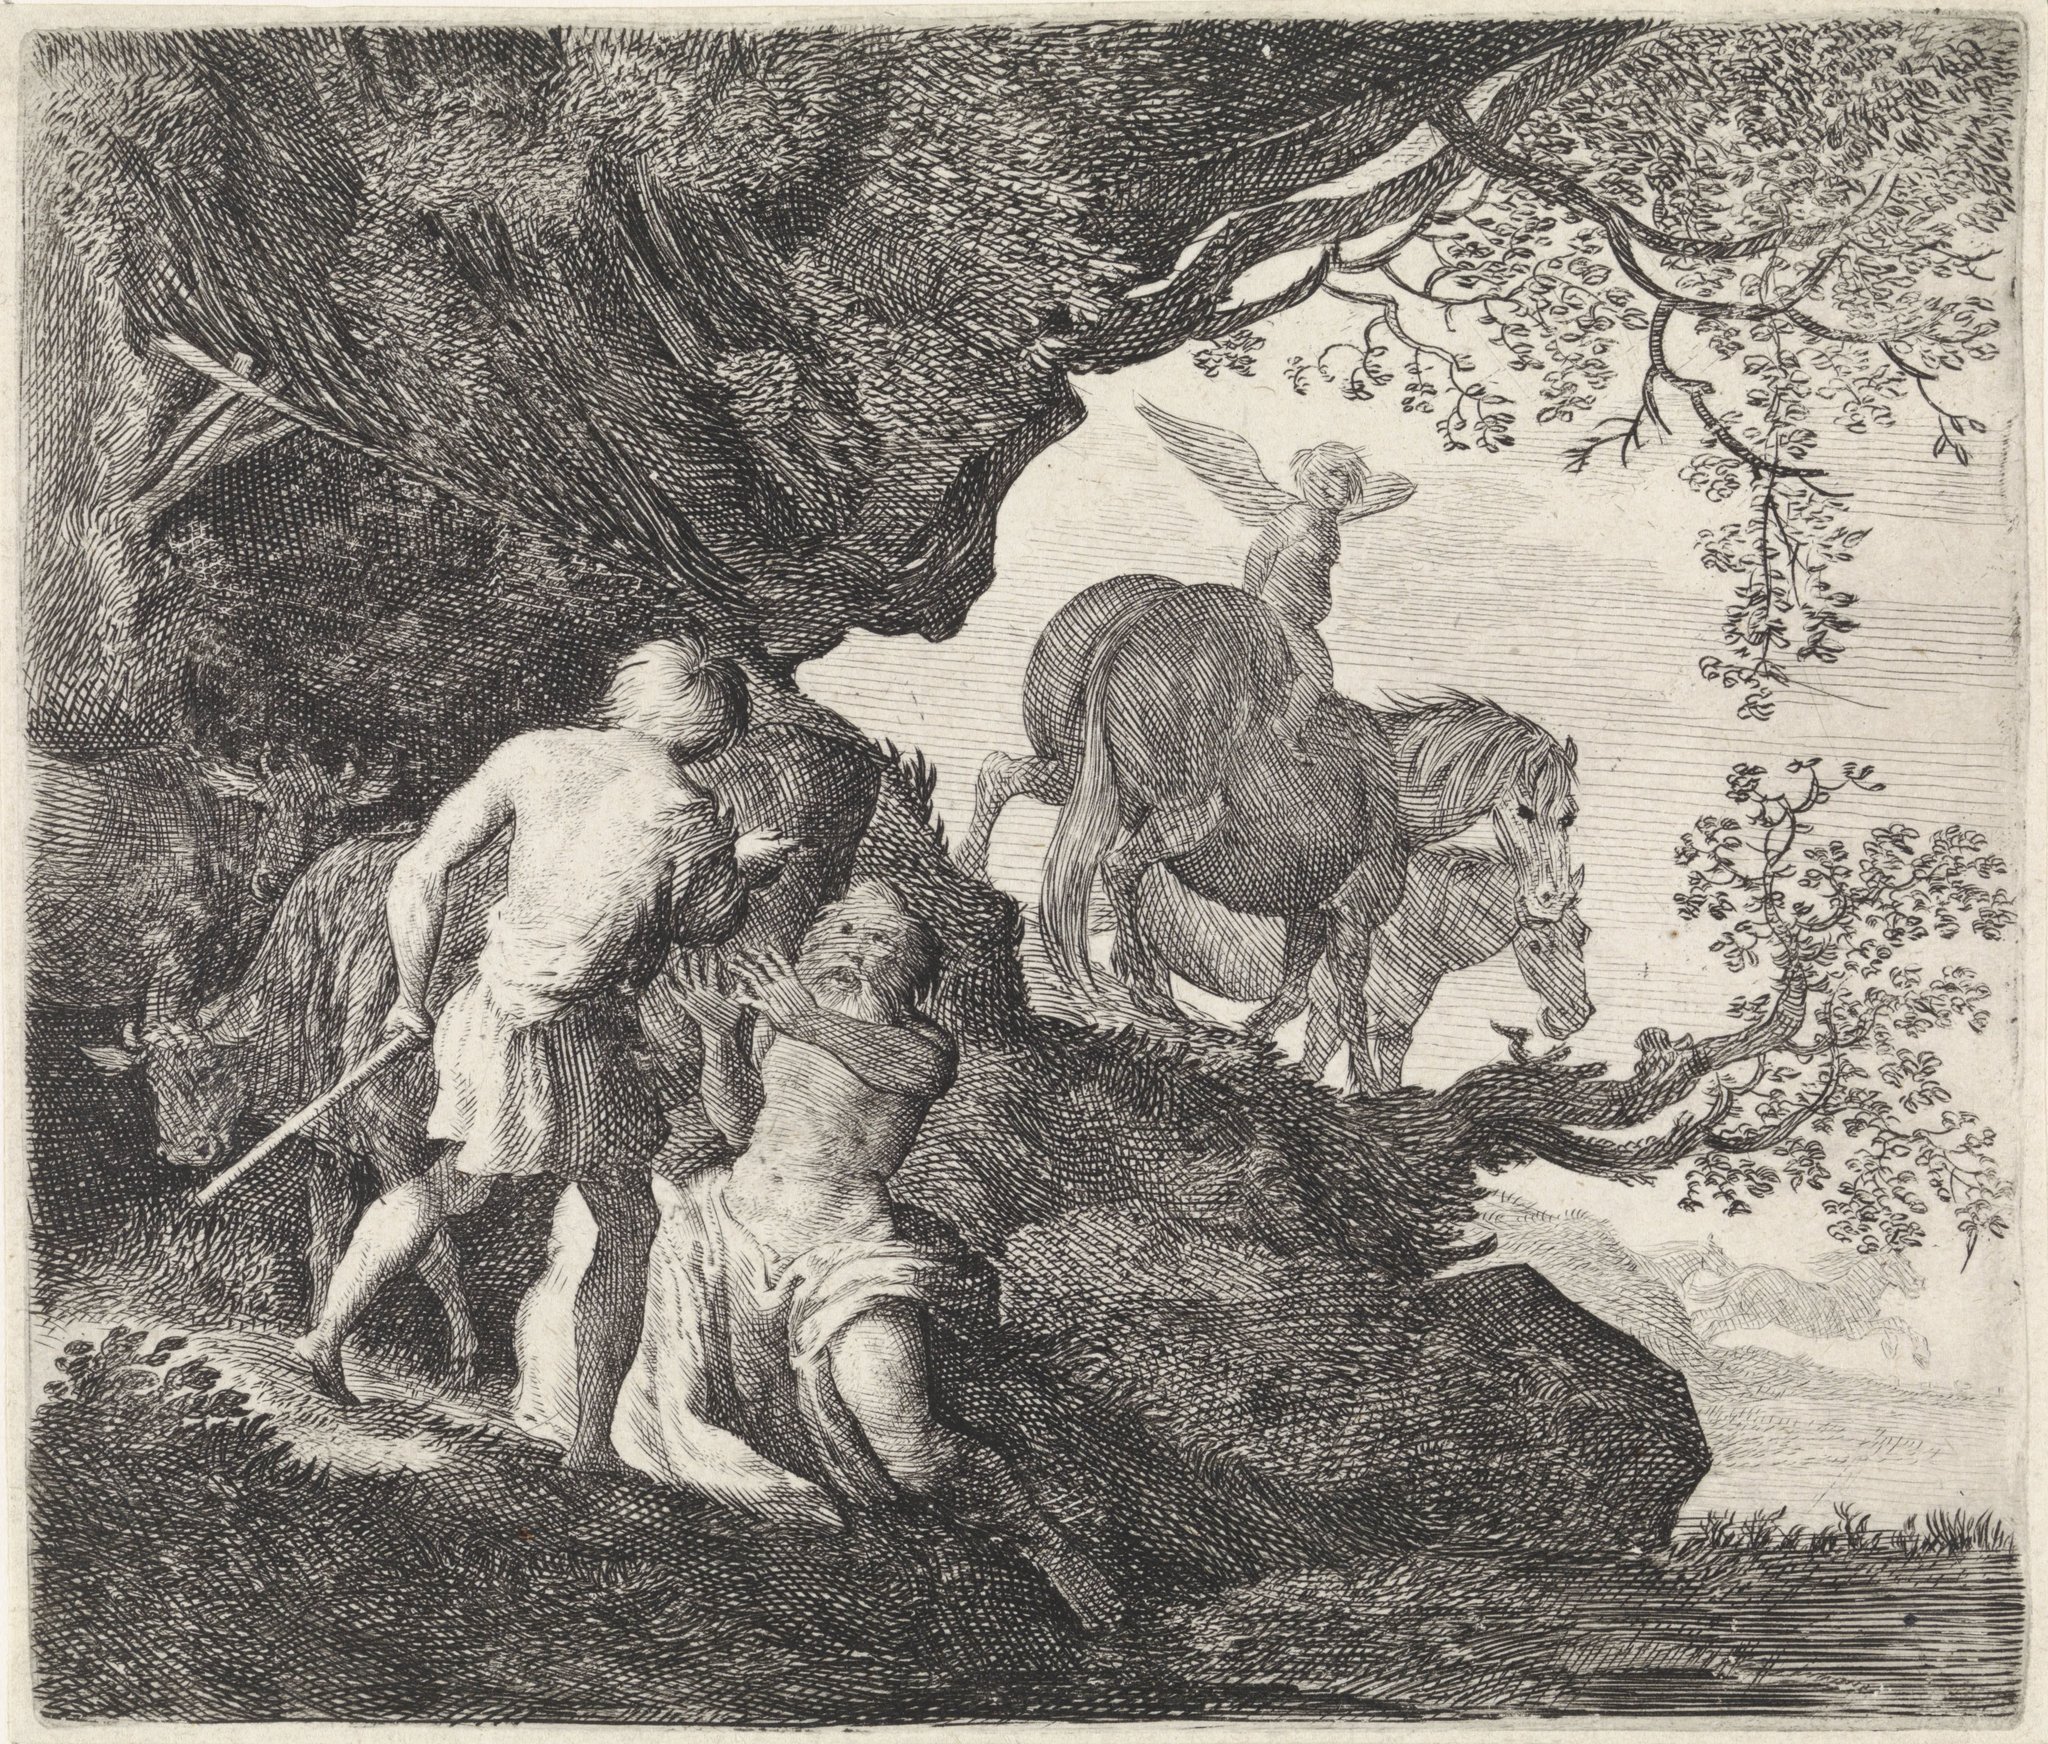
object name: print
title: Mercurius bestraft Battus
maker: moyses van wtenbrouck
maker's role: painter, print maker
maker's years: 1590-1647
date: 1600-1647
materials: paper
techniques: engraving, etching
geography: the hague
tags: battus changed into a touchstone: for violating the promise to keep mercury's theft of apollo's cattle a secret, mercury turns battus, the shepherd, into a touchstone (ovid, metamorphoses ii 705)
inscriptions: collector's mark: Lugt 240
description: Battus zit op zijn knieën in afwerende houding voor Mercurius. Omdat hij zijn belofte niet heeft gehouden, zal Mercurius hem als straf veranderen in een steen. Scène uit Ovidius’ Metamorfosen (Met. II, 704-707).